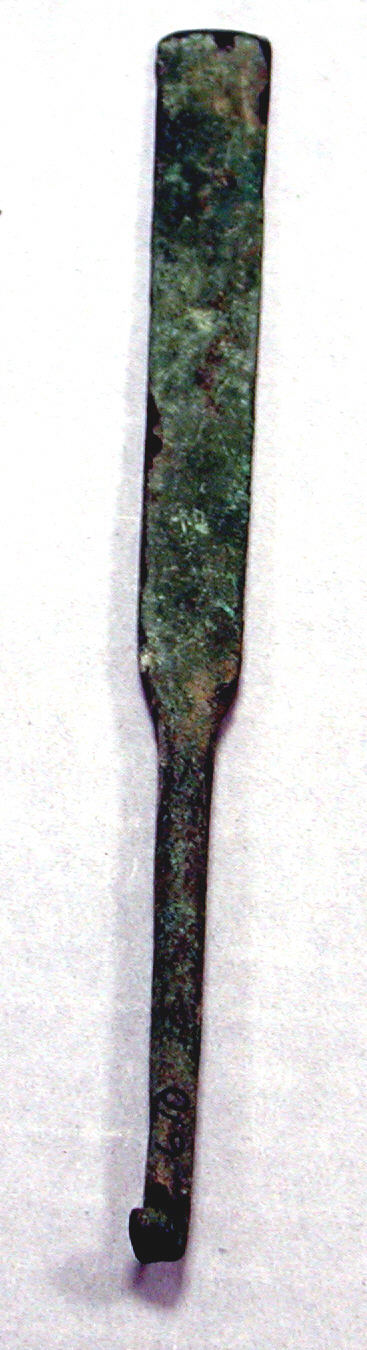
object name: chisel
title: Hammered Copper Chisel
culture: peruvian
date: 1-1566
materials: copper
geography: peru